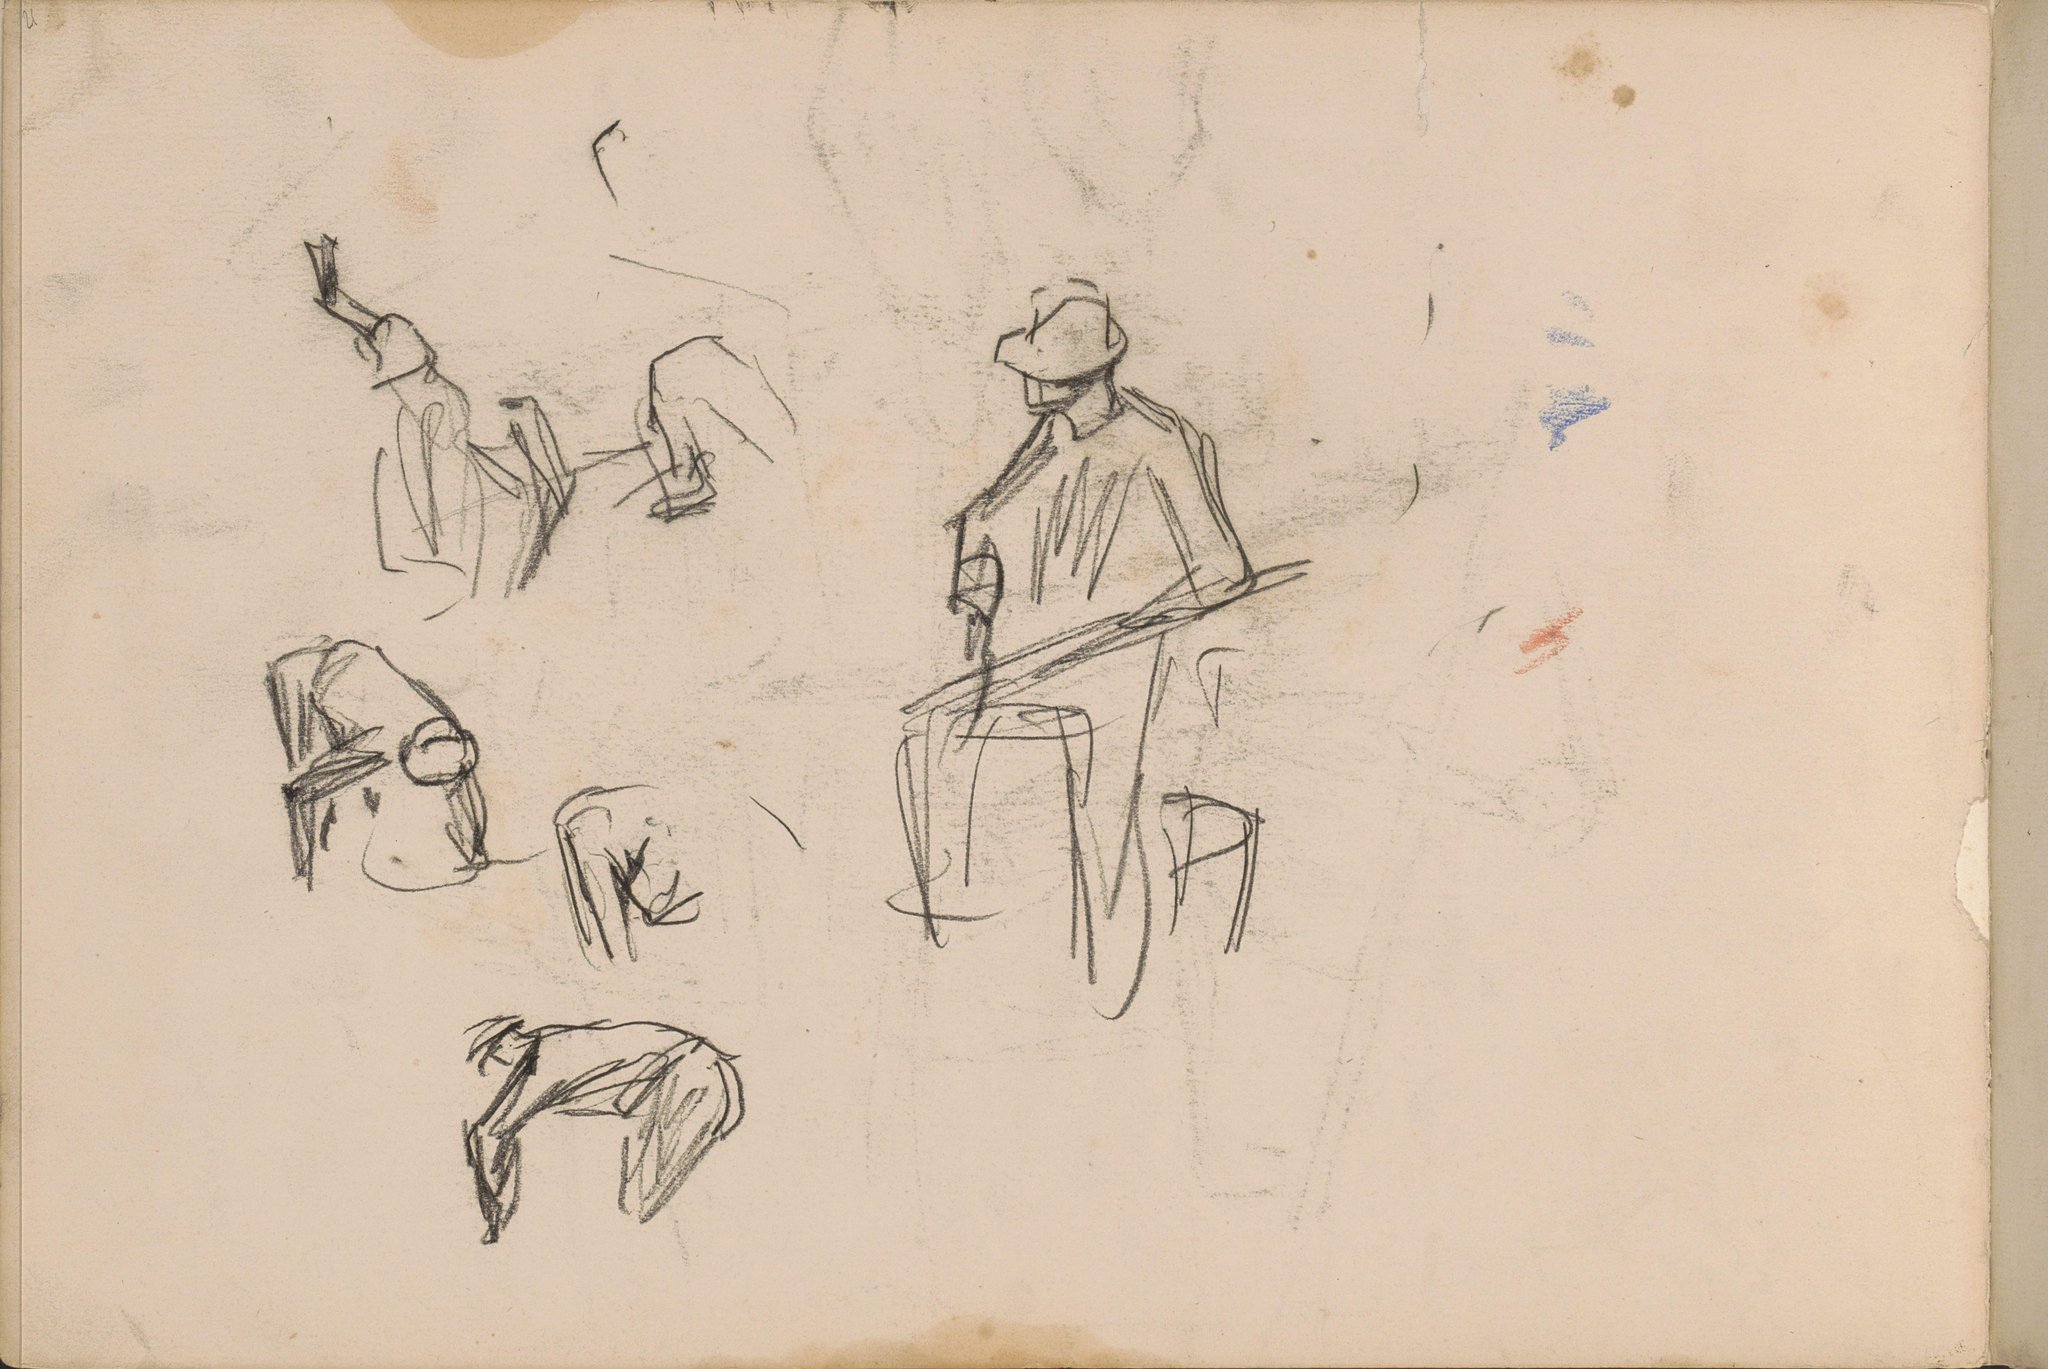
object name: sketchbook leaf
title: Figuurstudies, onder andere van een zittende man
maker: george hendrik breitner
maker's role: draughtsman, painter, print maker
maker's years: 1857-1923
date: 1898-1914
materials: chalk, paper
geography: amsterdam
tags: sitting figure, adult man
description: Pagina 21 uit een schetsboek met 21 bladen.